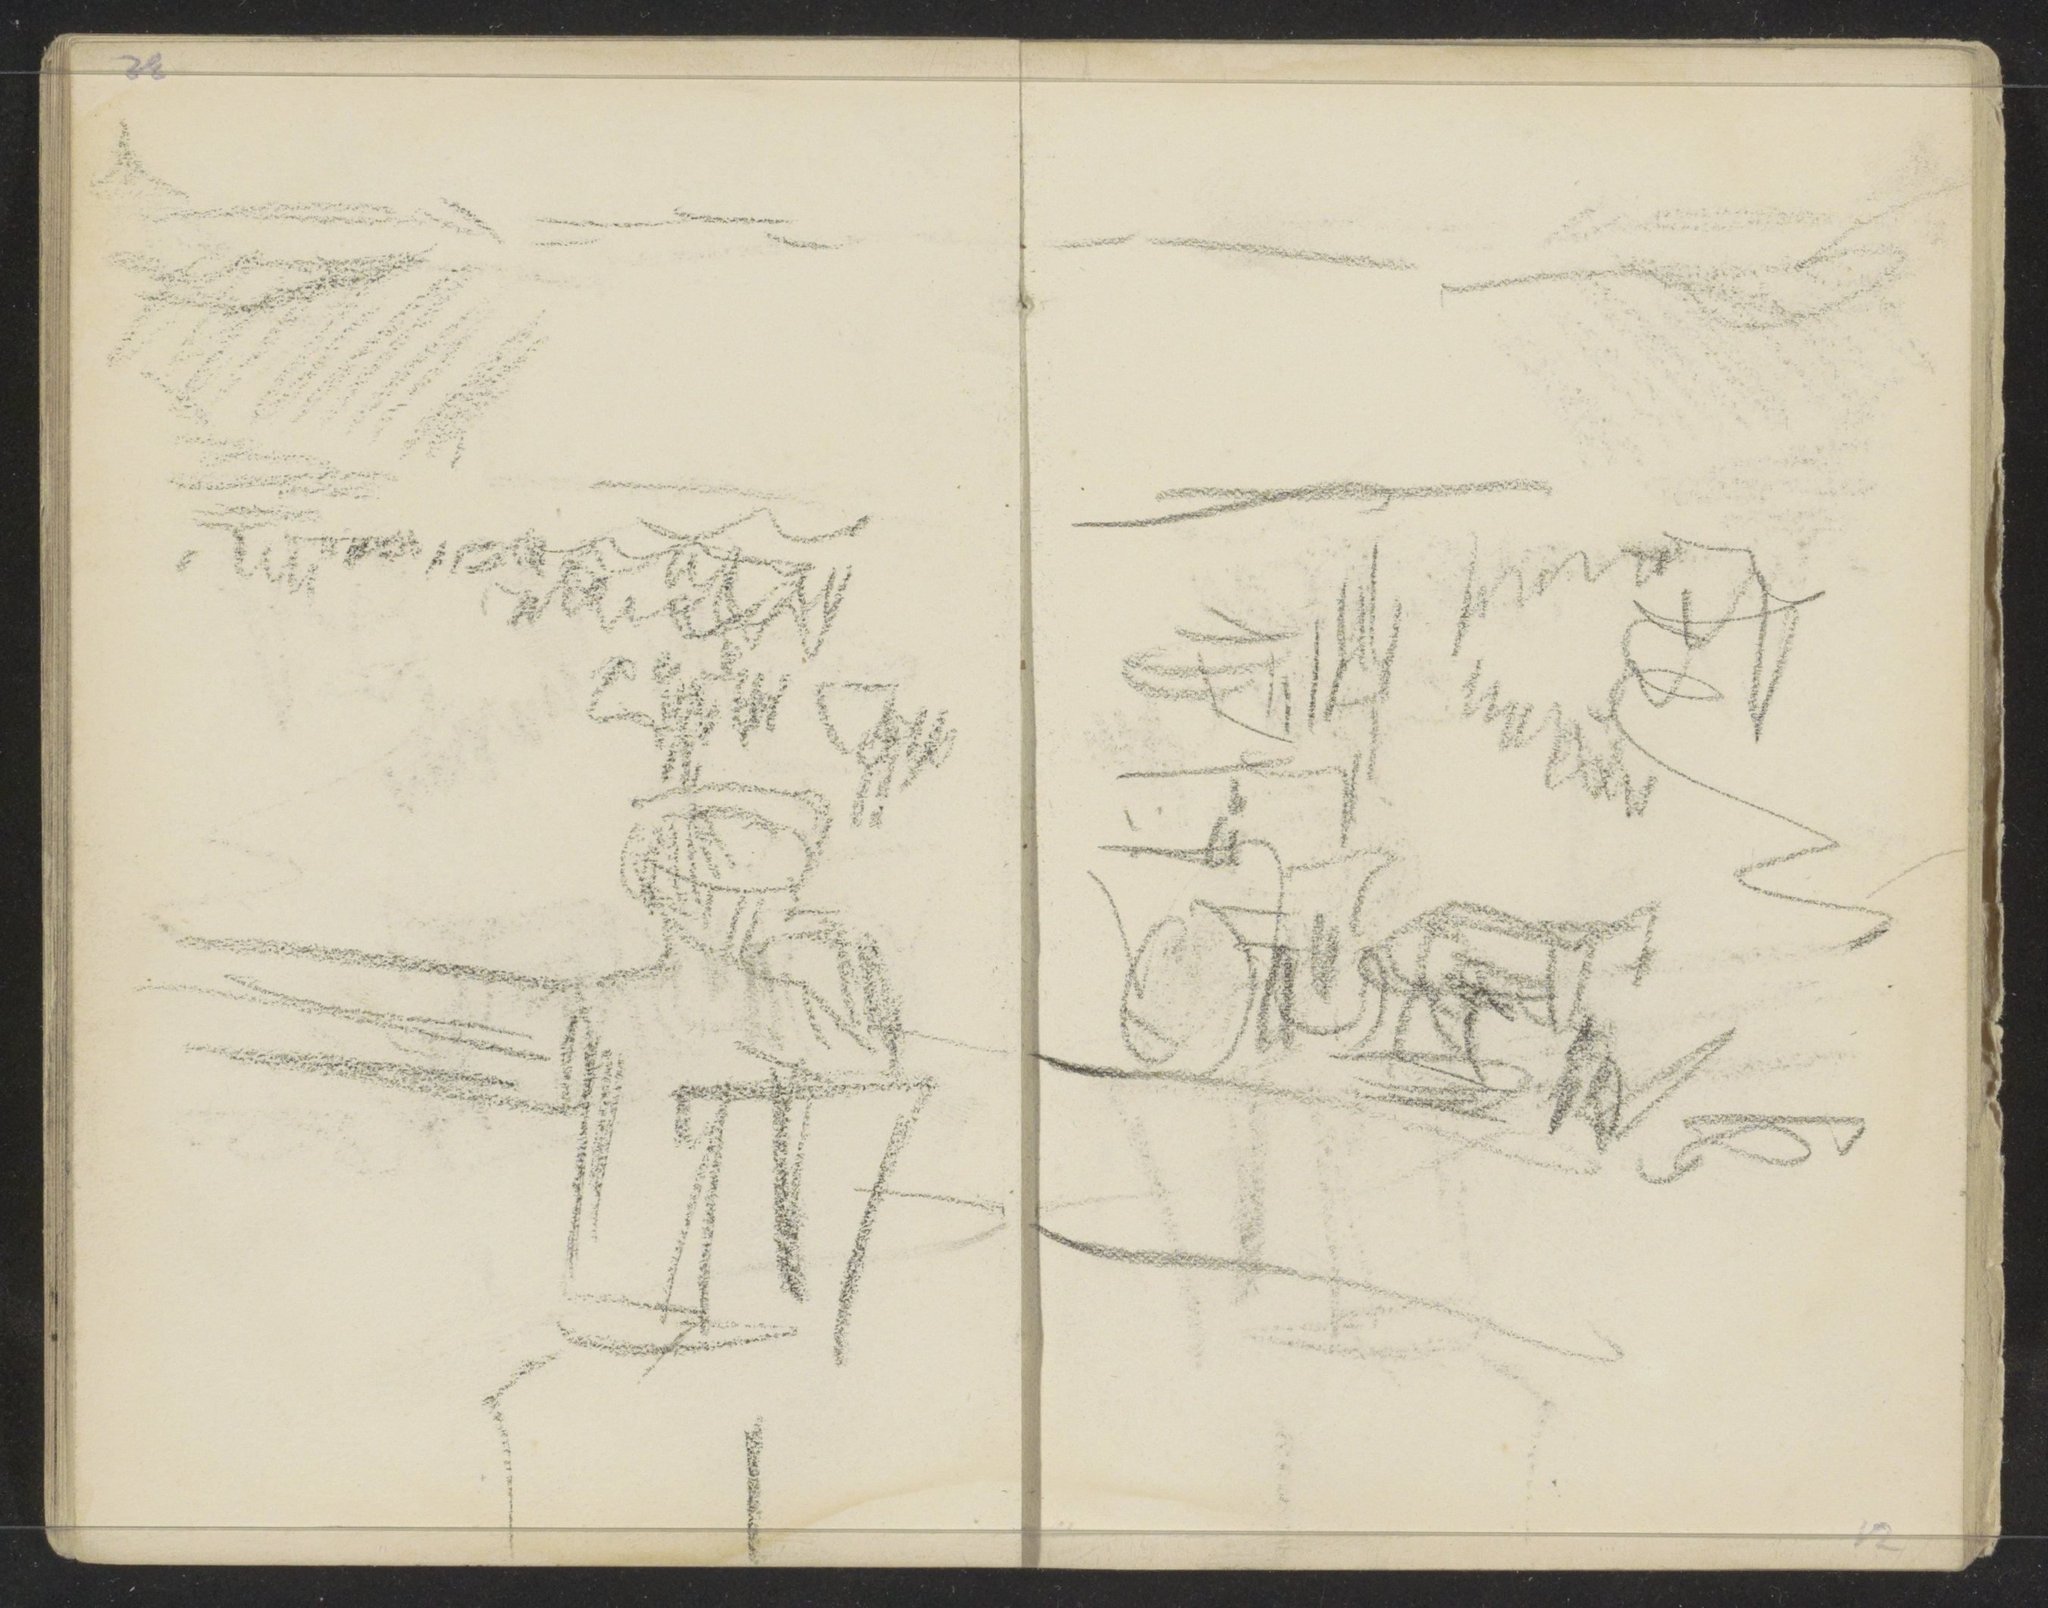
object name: sketchbook leaf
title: Vrouw kijkt naar een rijtuig, mogelijk vanaf een balkon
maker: isaac israels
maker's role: draughtsman, painter, print maker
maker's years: 1865-1934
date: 1887-1934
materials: chalk, paper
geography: paris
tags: four-wheeled, animal-drawn vehicle, e.g.: cab, carriage, coach, adult woman (+ sitting), balcony, chair, street (+ city(-scape) with figures, staffage), paris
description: Ze zit op een stoel. Blad 11 verso en blad 12 recto uit schetsboek LIX met 21 bladen.